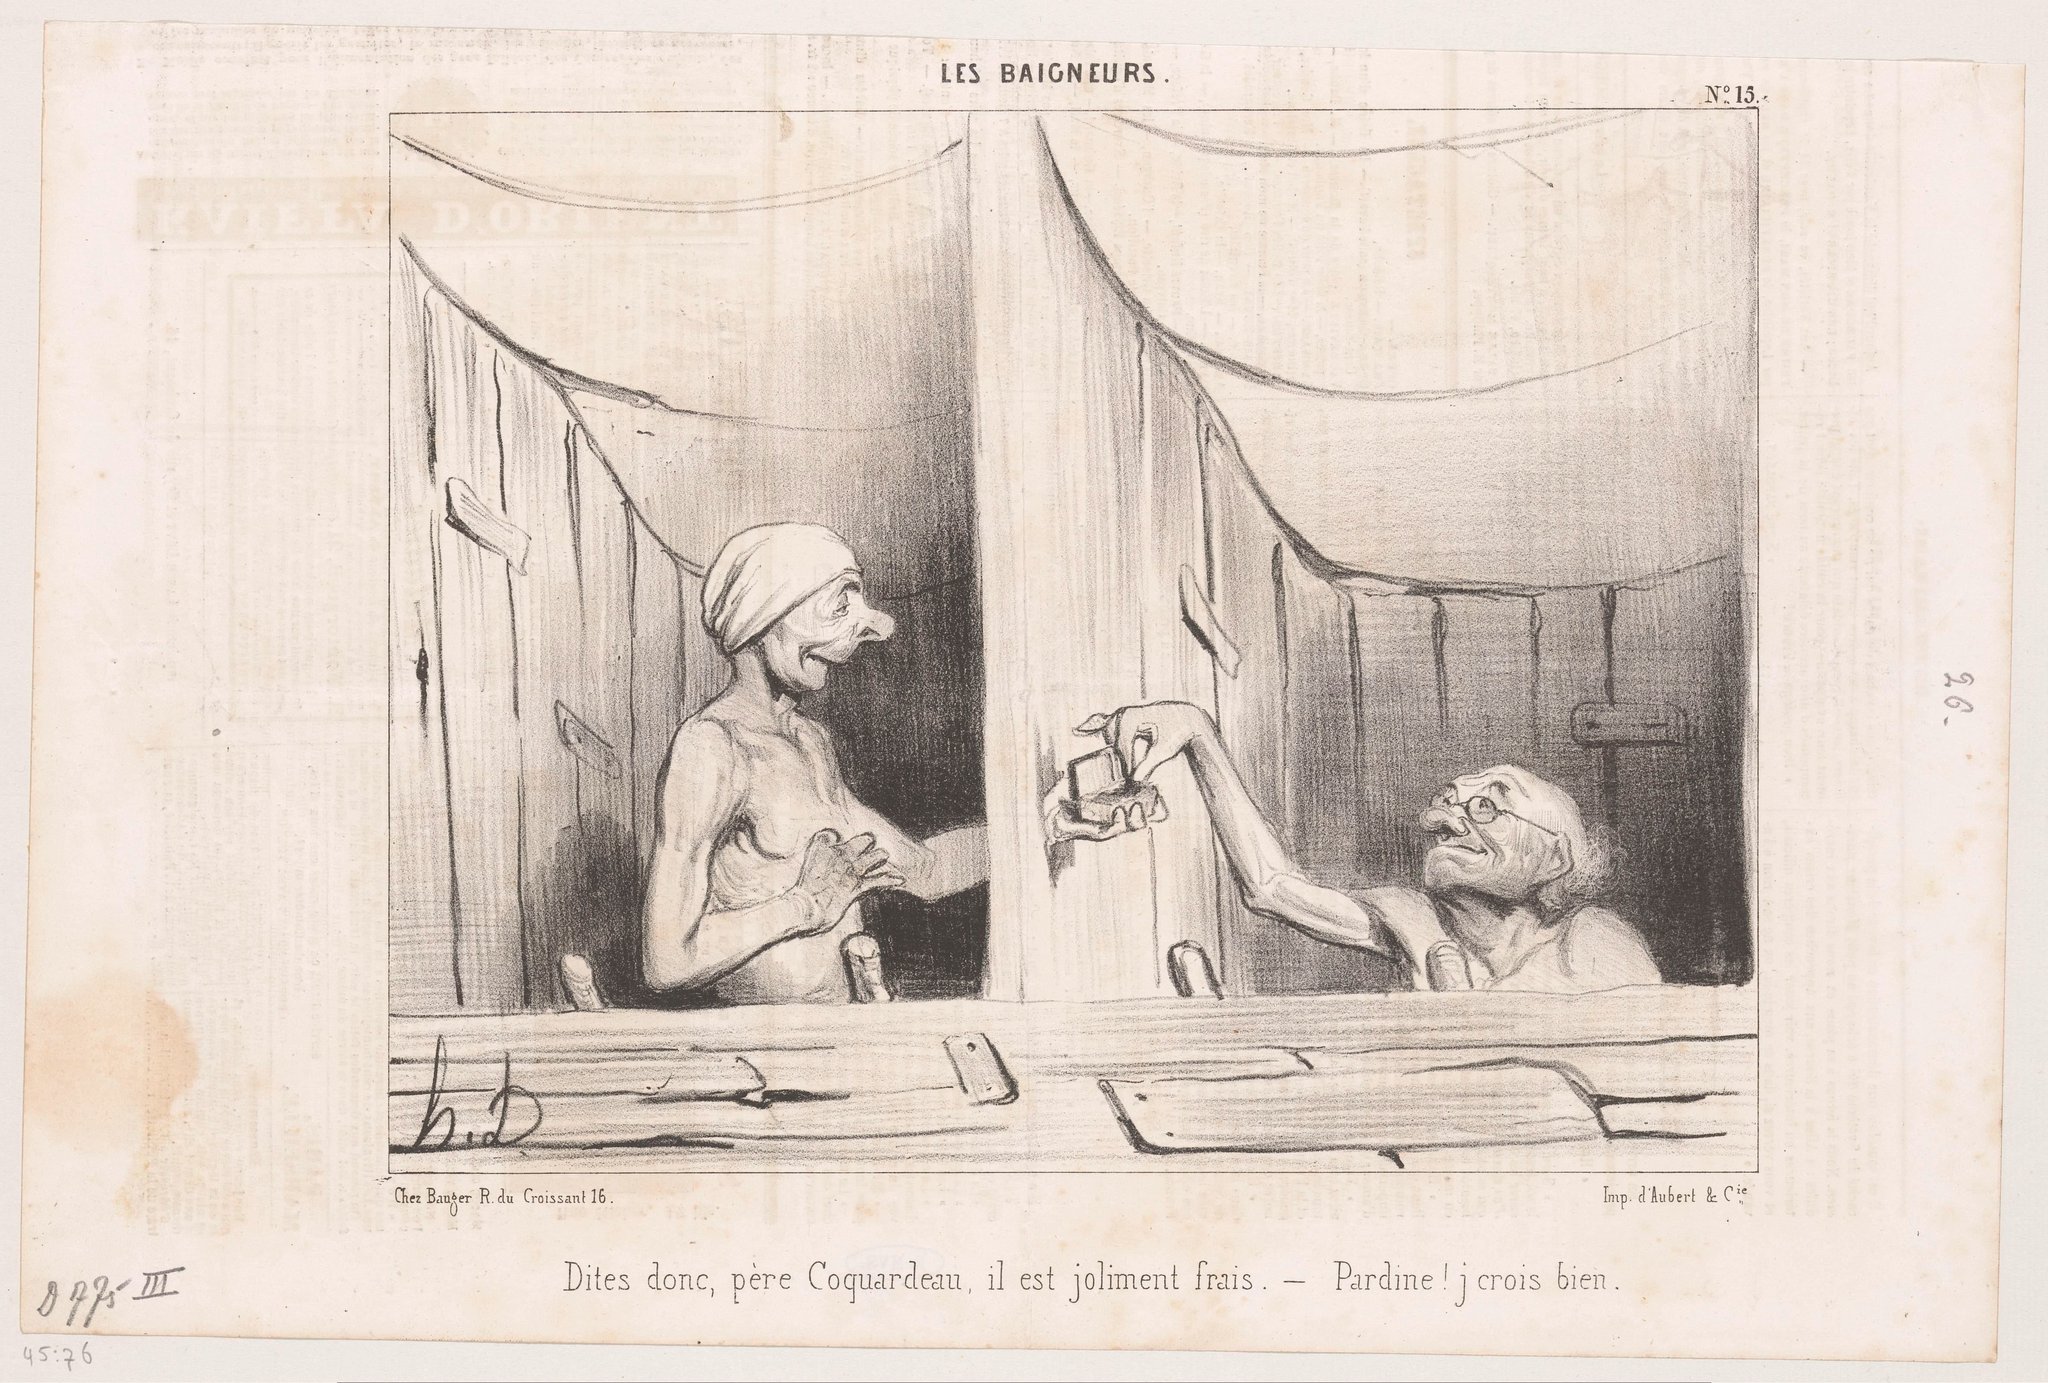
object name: cartoon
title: Les baigneurs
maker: honoré daumier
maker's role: draughtsman, painter, print maker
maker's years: 1808-1879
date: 1840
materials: paper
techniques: letterpress printing, lithograph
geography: paris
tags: snuff-box, caricatures (human types), public baths (+ two together)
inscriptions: collector's mark: Lugt 2228a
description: Prent mogelijk uit: Le Charivari, 9 augustus 1840.